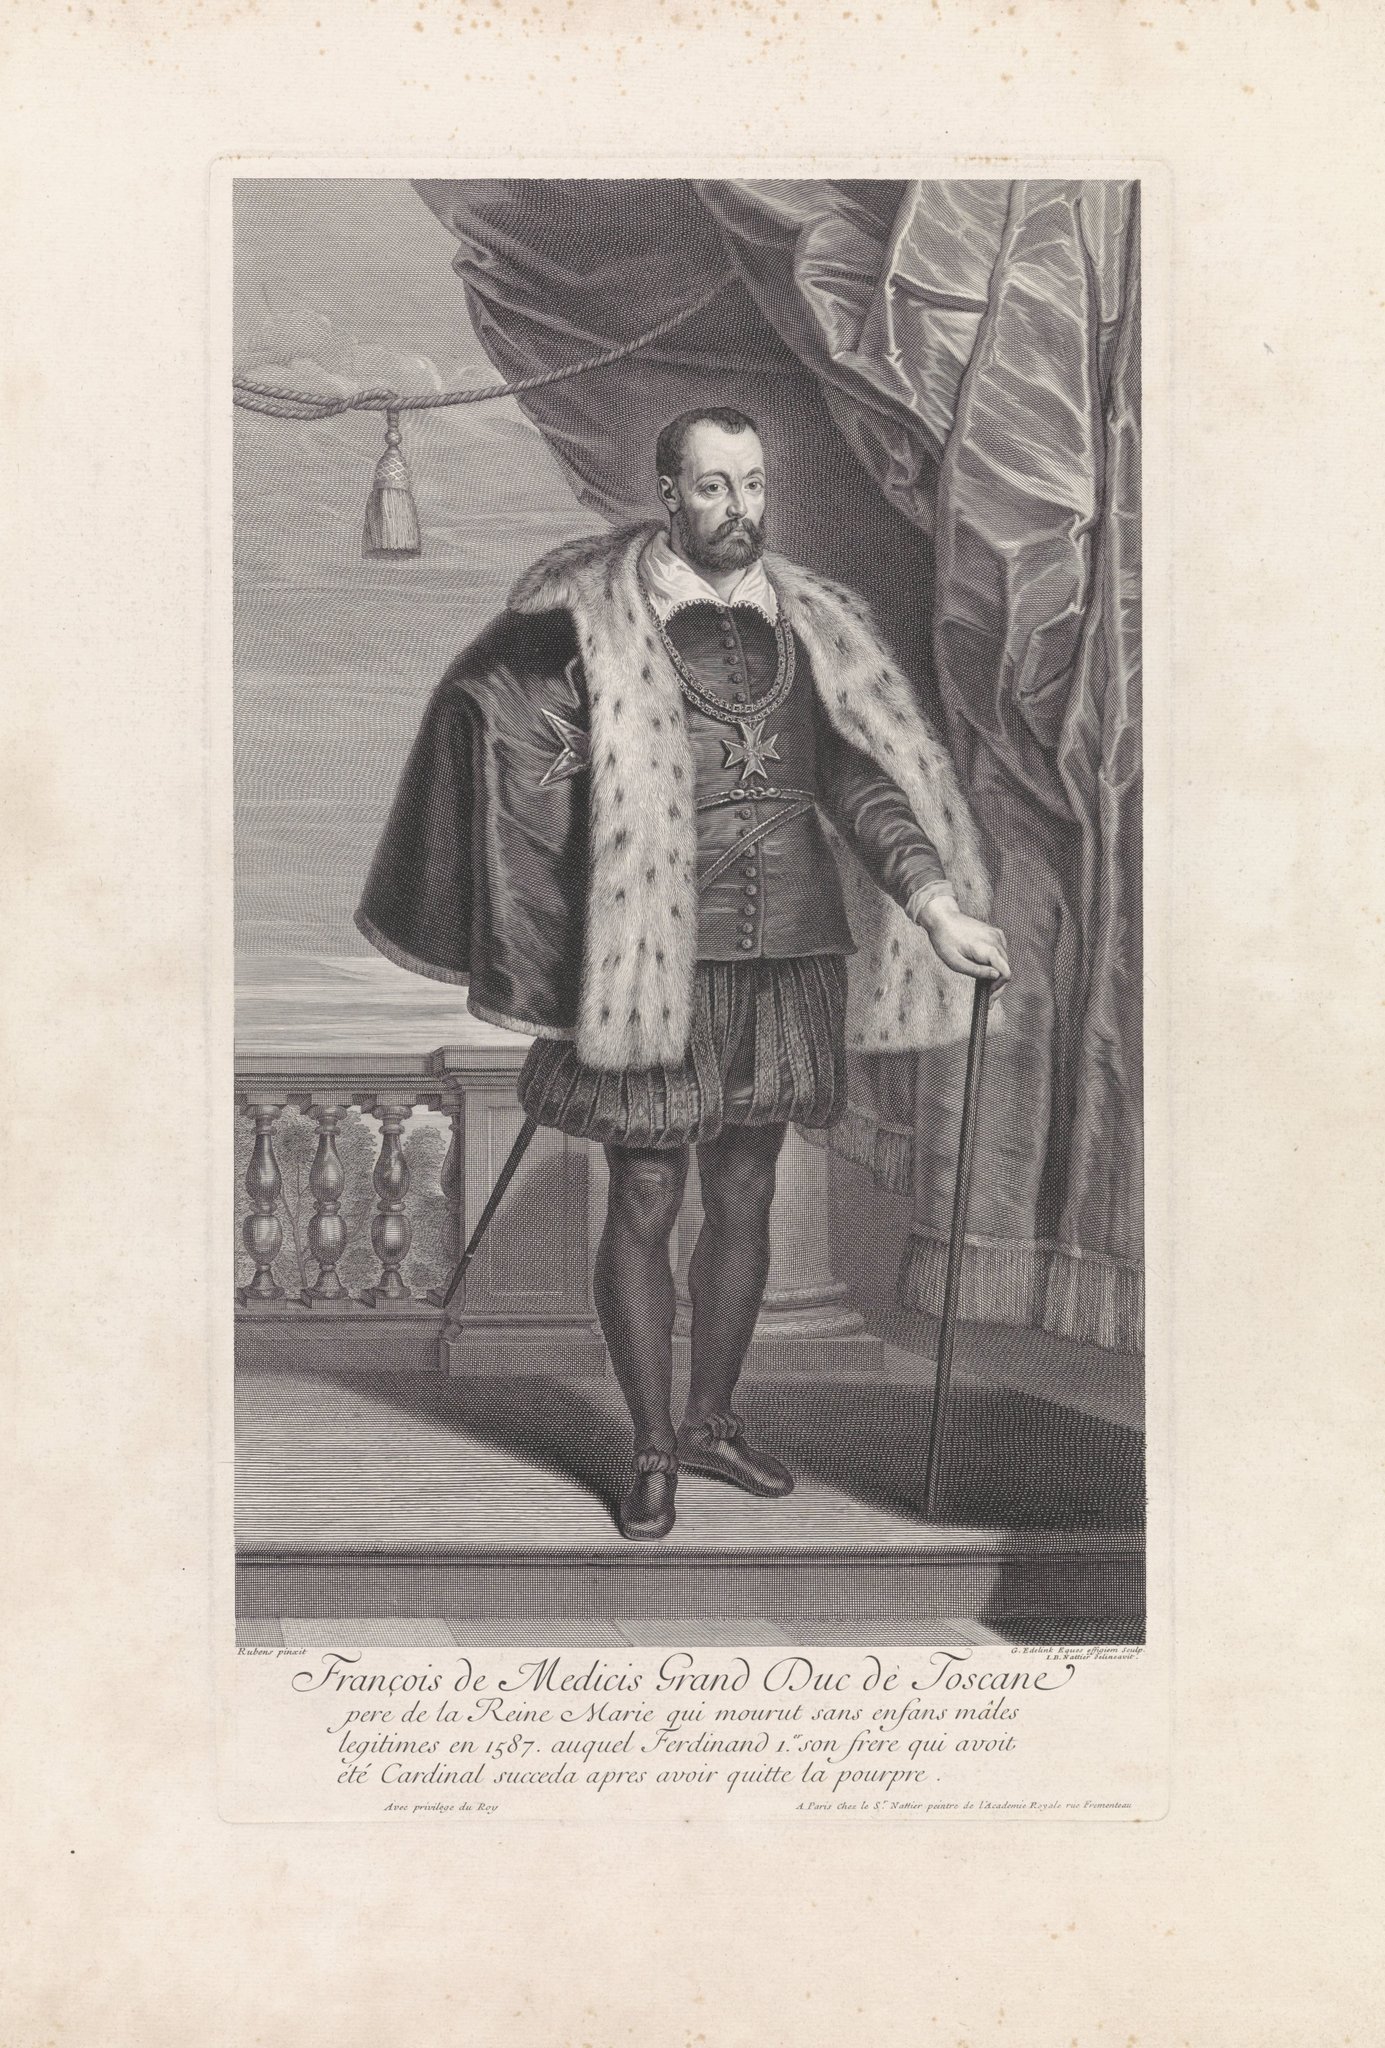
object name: print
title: Portret van Francesco I de' Medici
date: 1666-1707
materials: paper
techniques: engraving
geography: paris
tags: francesco i de' medici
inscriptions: collector's mark: Lugt 240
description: Francesco de' Medici, groothertog van Toscane, ten voeten uit afgebeeld met bontmantel en wandelstok. Op de achtergrond een balustrade met draperie. Onder de voorstelling vier regels in het Frans.